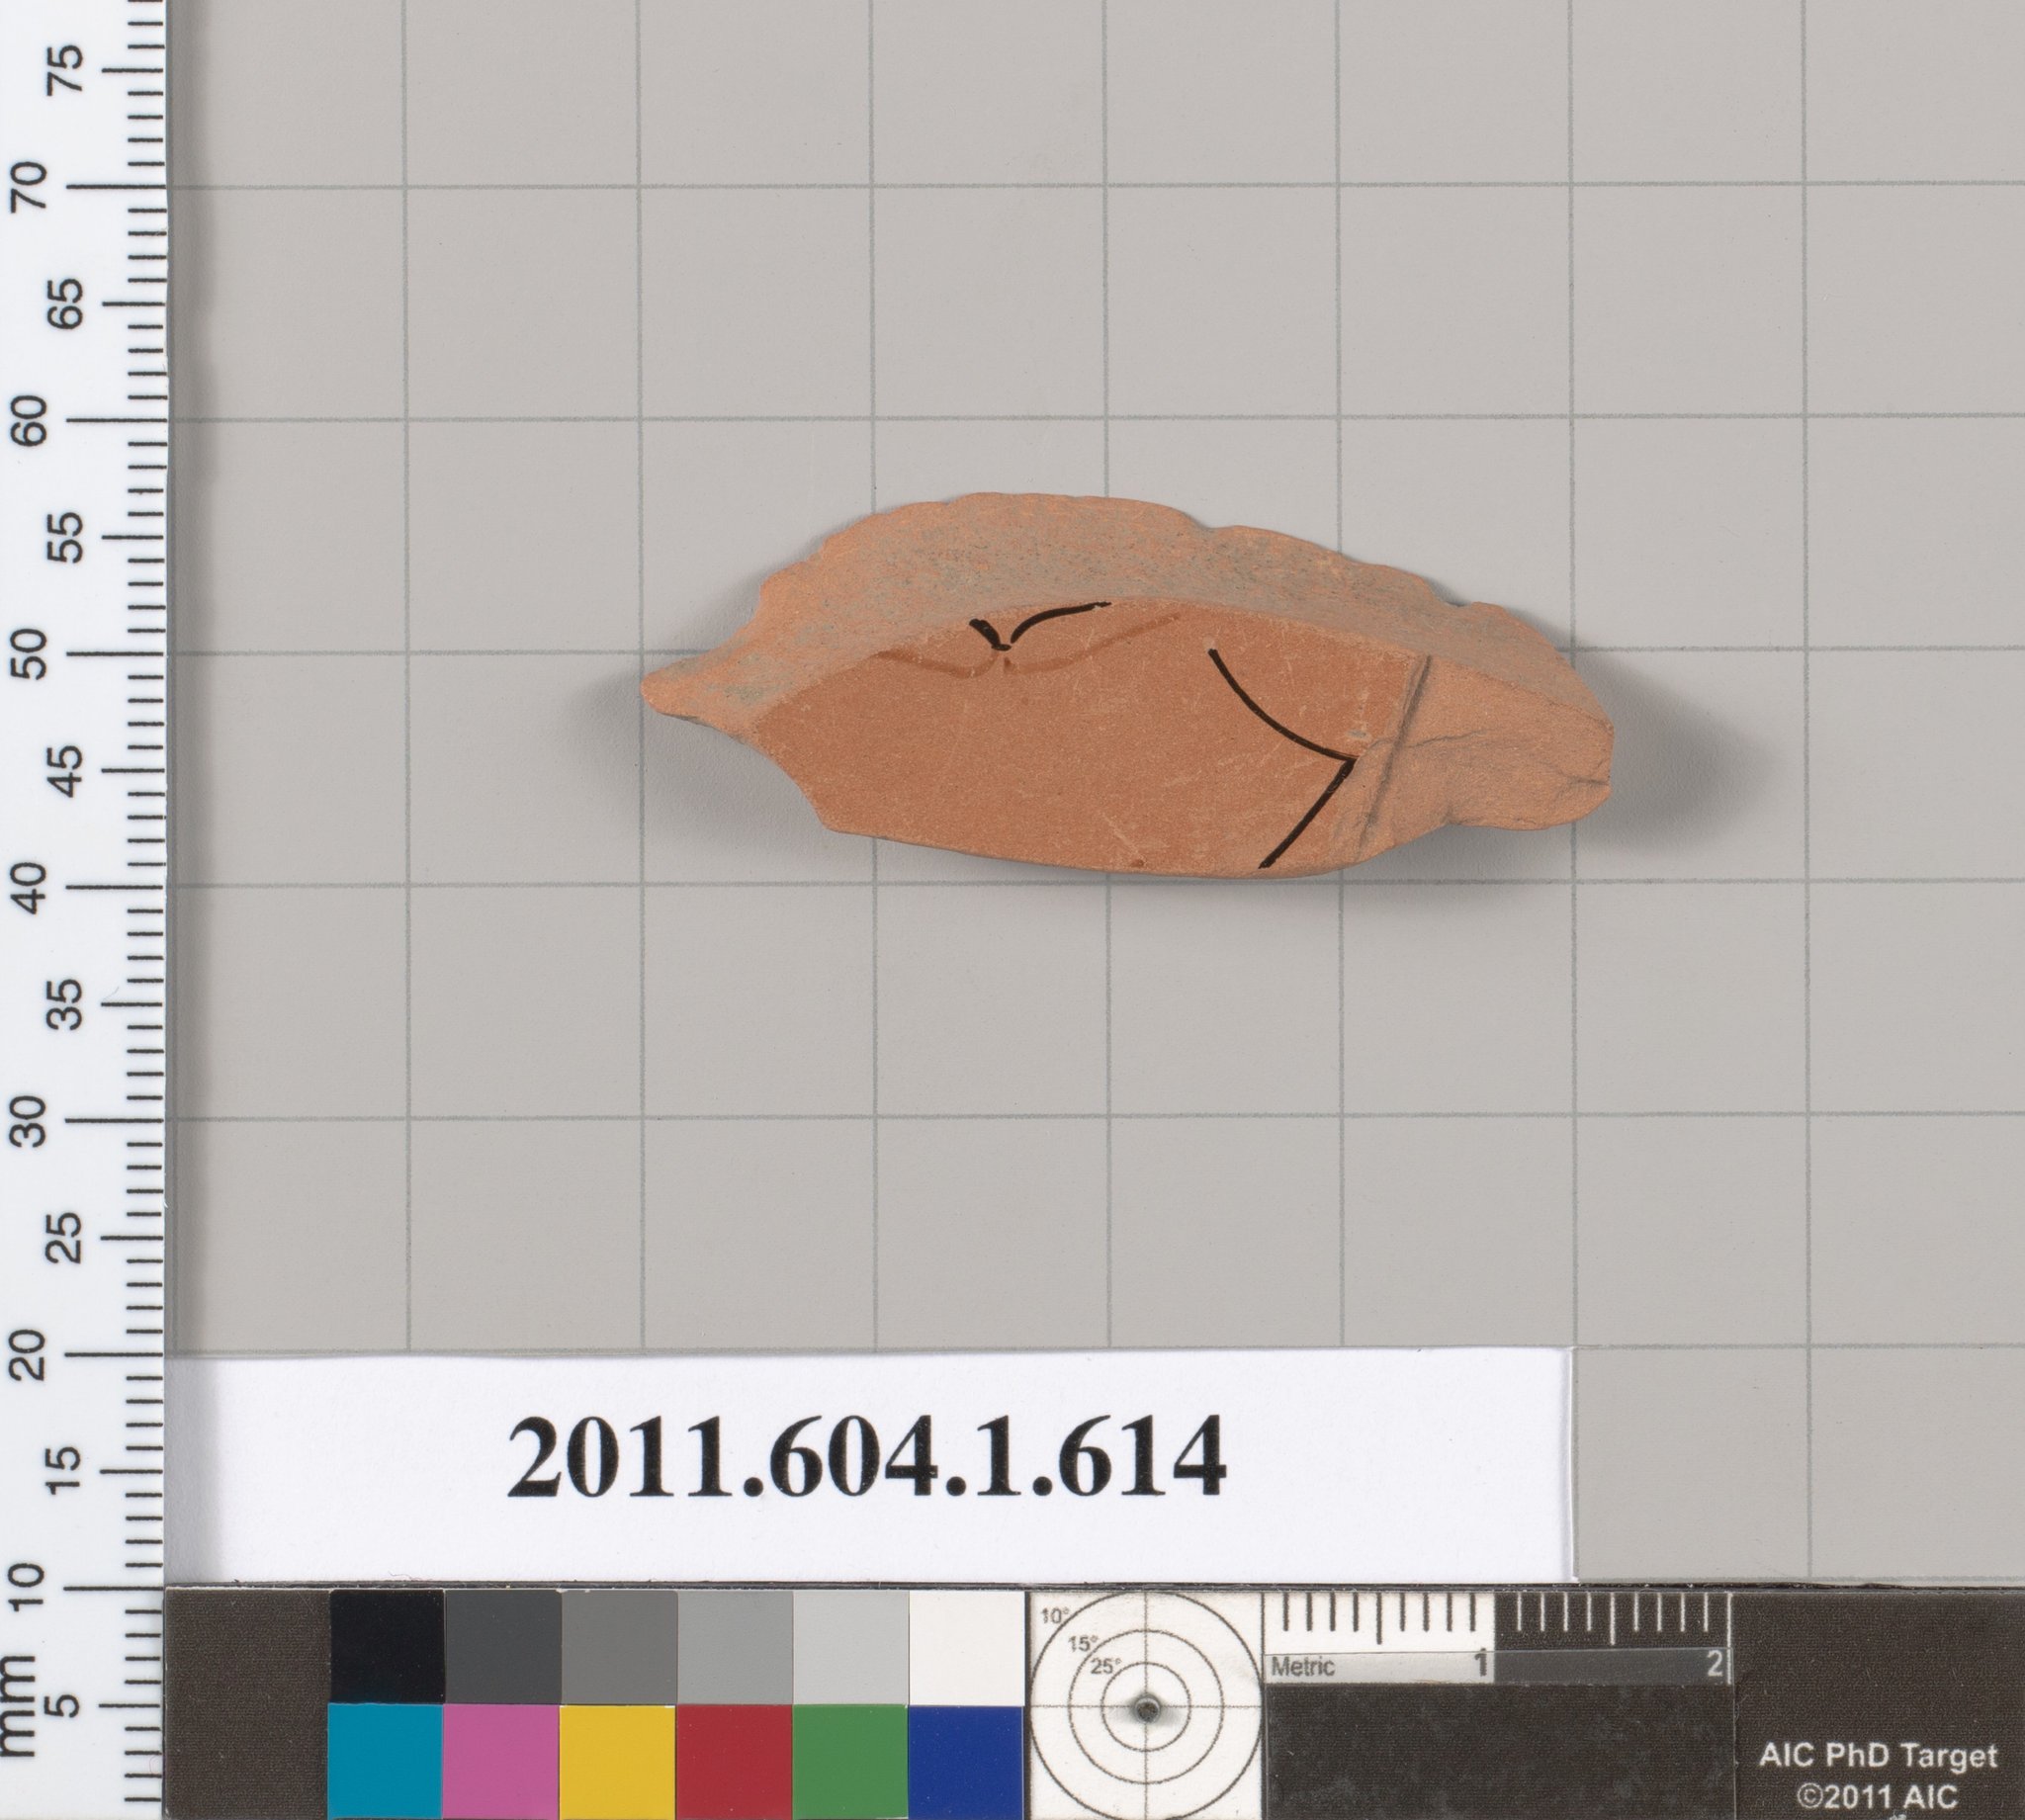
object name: kylix fragment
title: Terracotta fragment of a kylix (drinking cup)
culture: greek, attic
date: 475-451 BCE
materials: terracotta